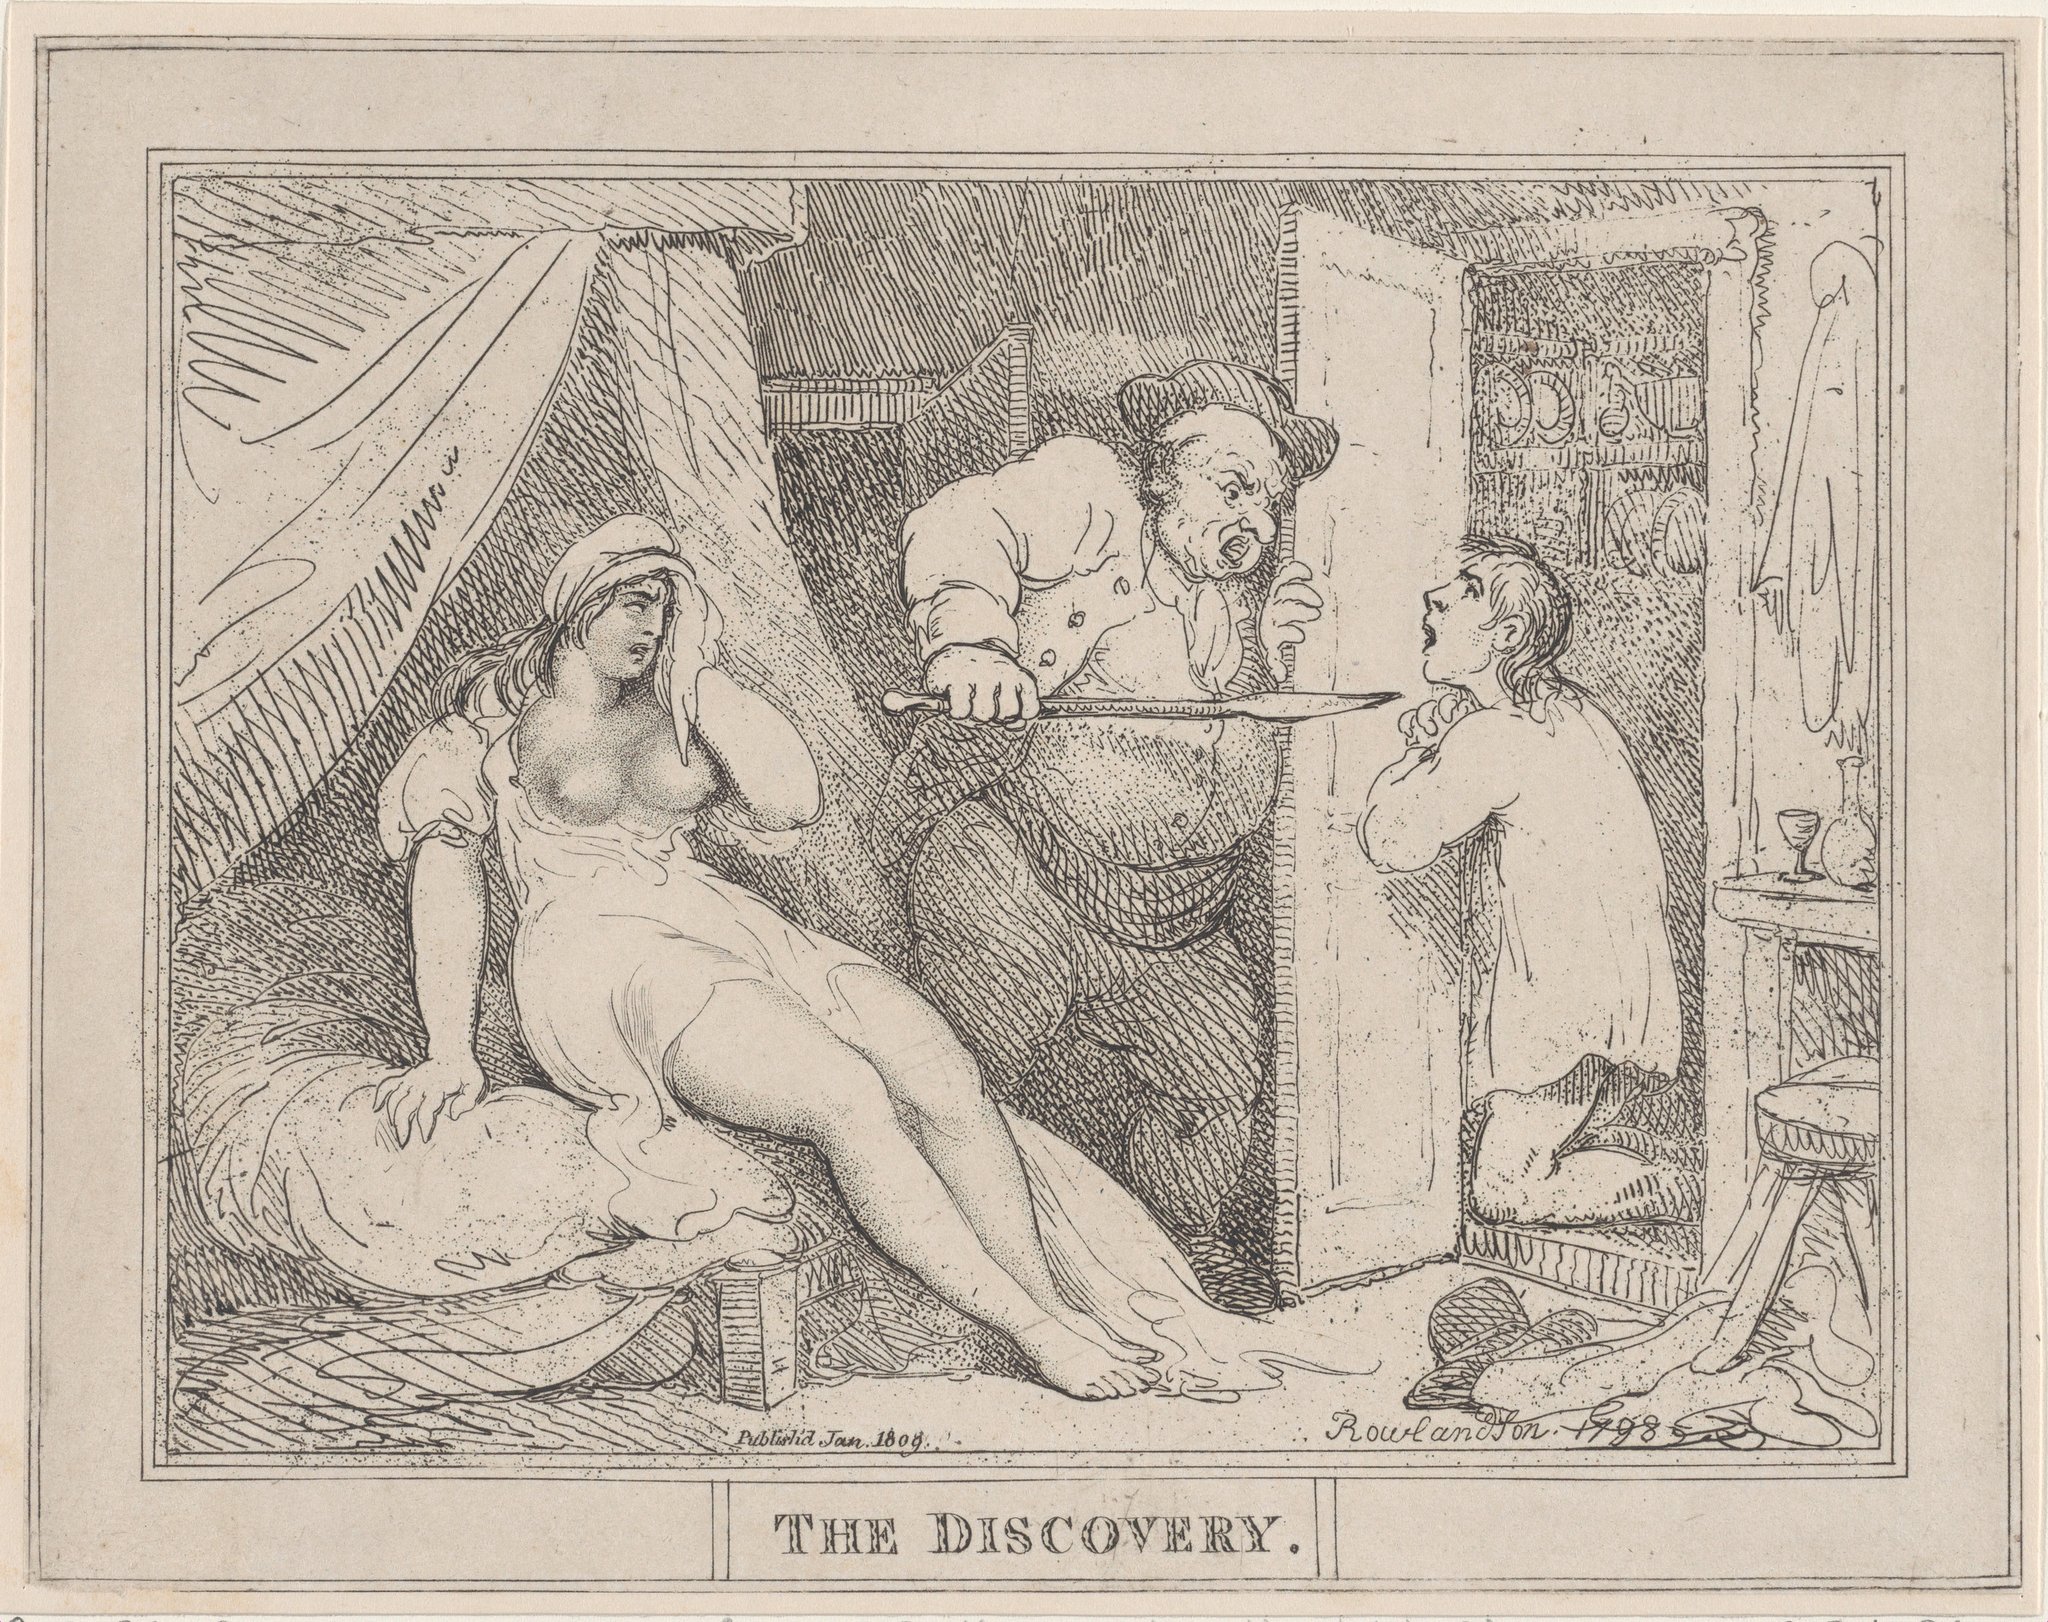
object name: print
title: The Discovery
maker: thomas rowlandson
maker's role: artist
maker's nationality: british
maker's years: 1757-1827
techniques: etching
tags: satire,men,women,female nudes,beds